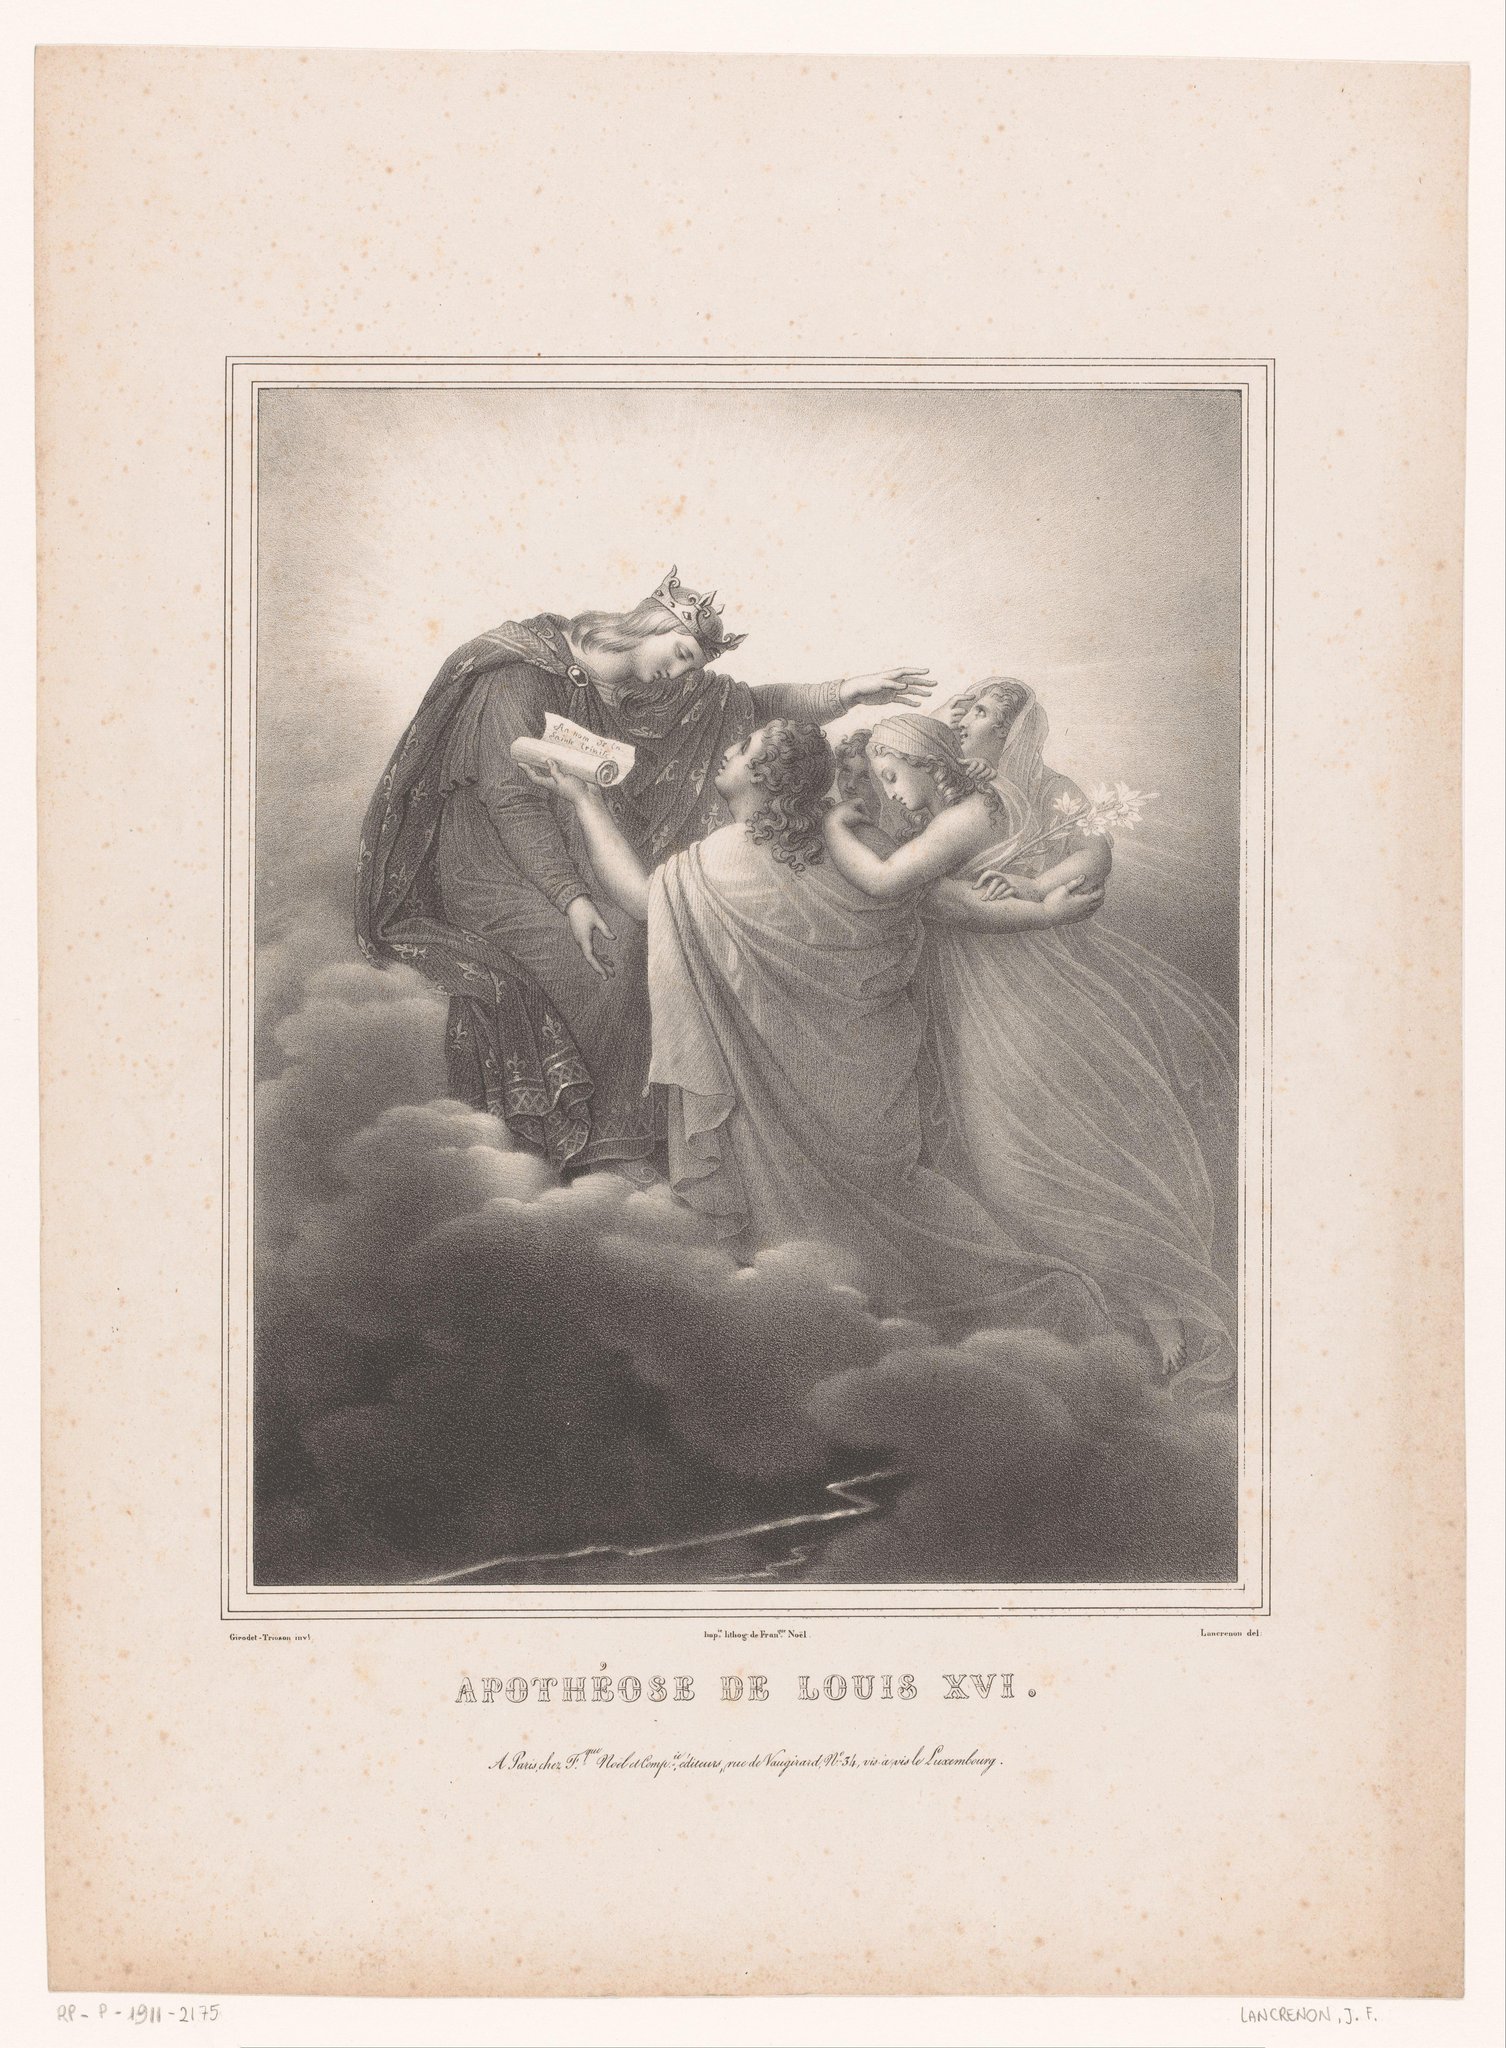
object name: print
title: Verheerlijking van Lodewijk XVI van Frankrijk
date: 1820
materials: paper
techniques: lithograph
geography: paris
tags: paris, lodewijk xvi (koning van frankrijk), historical persons, apotheosis of a ruler, king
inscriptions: collector's mark: Lugt 2228a